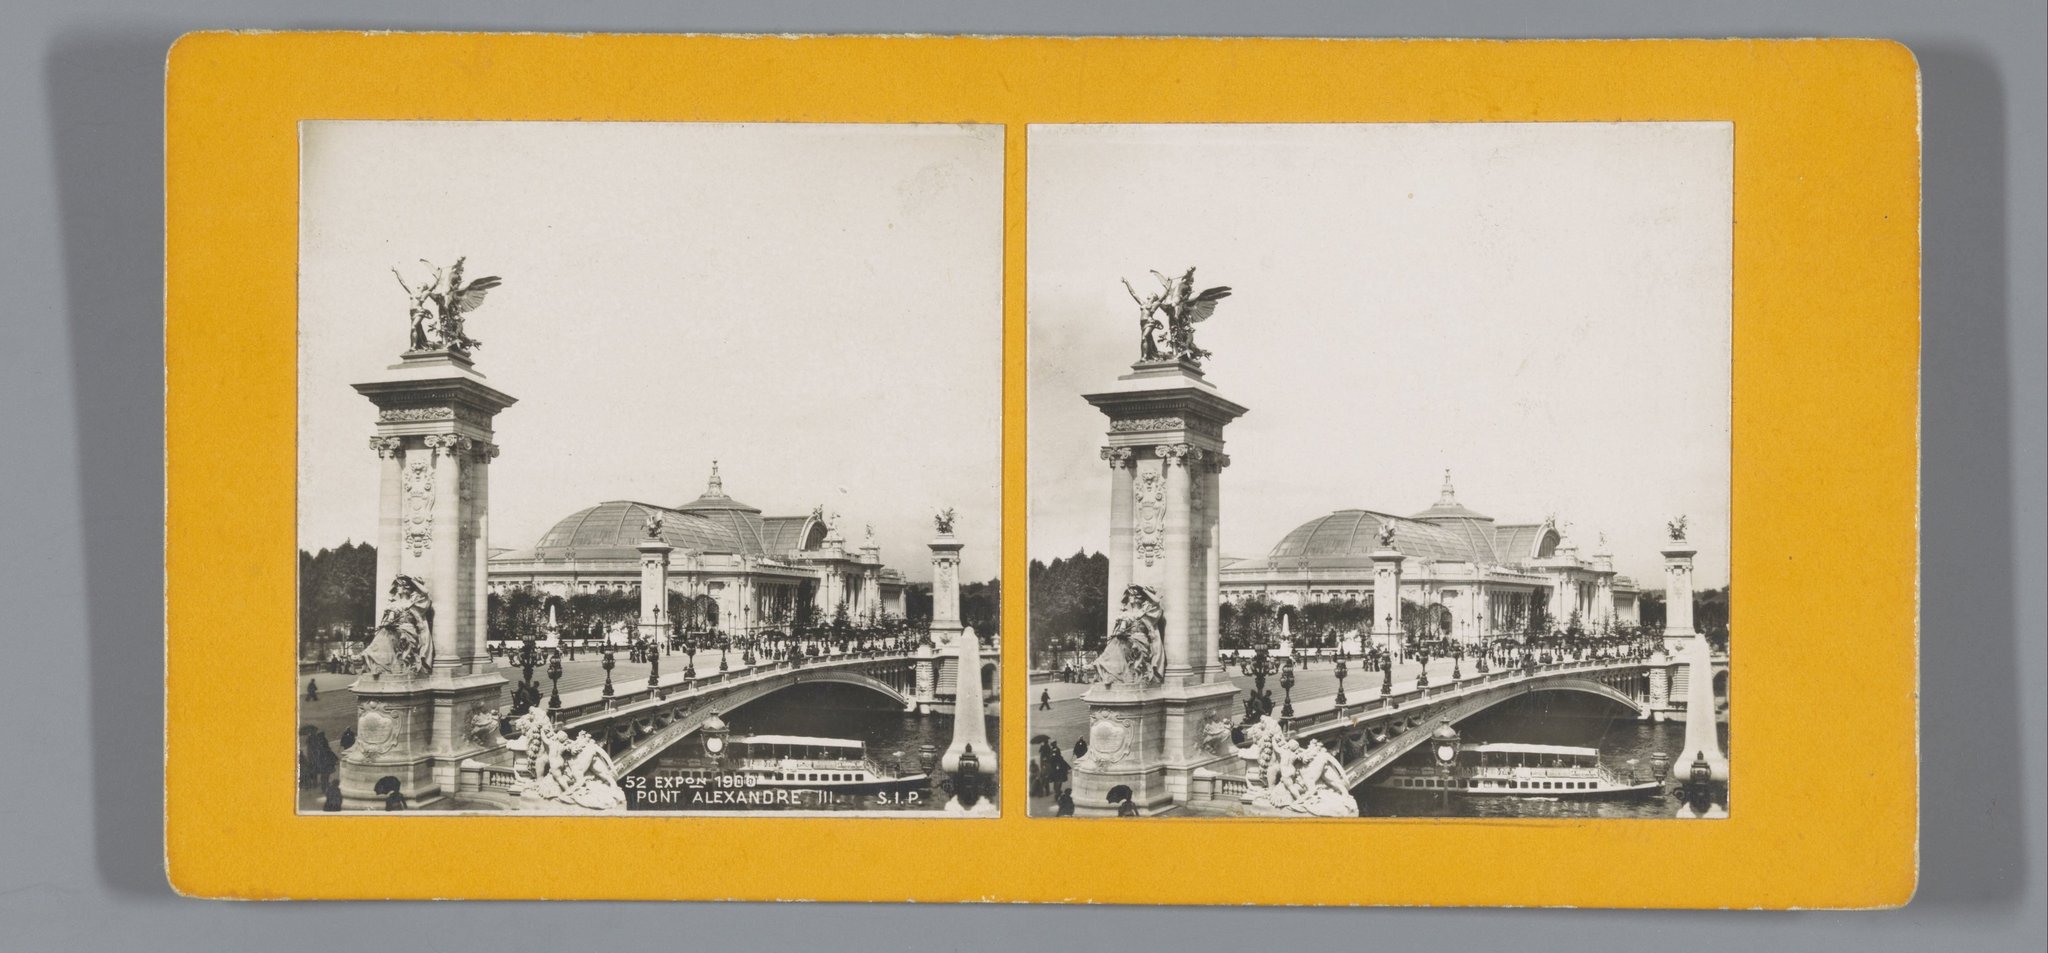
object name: stereograph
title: Expon 1900. Le Pont Alexandre III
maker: Anonymous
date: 1900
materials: paper, cardboard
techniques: gelatin silver print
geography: paris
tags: bridge, bridge in city across river, canal, etc., paris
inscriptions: number: ‘52.’